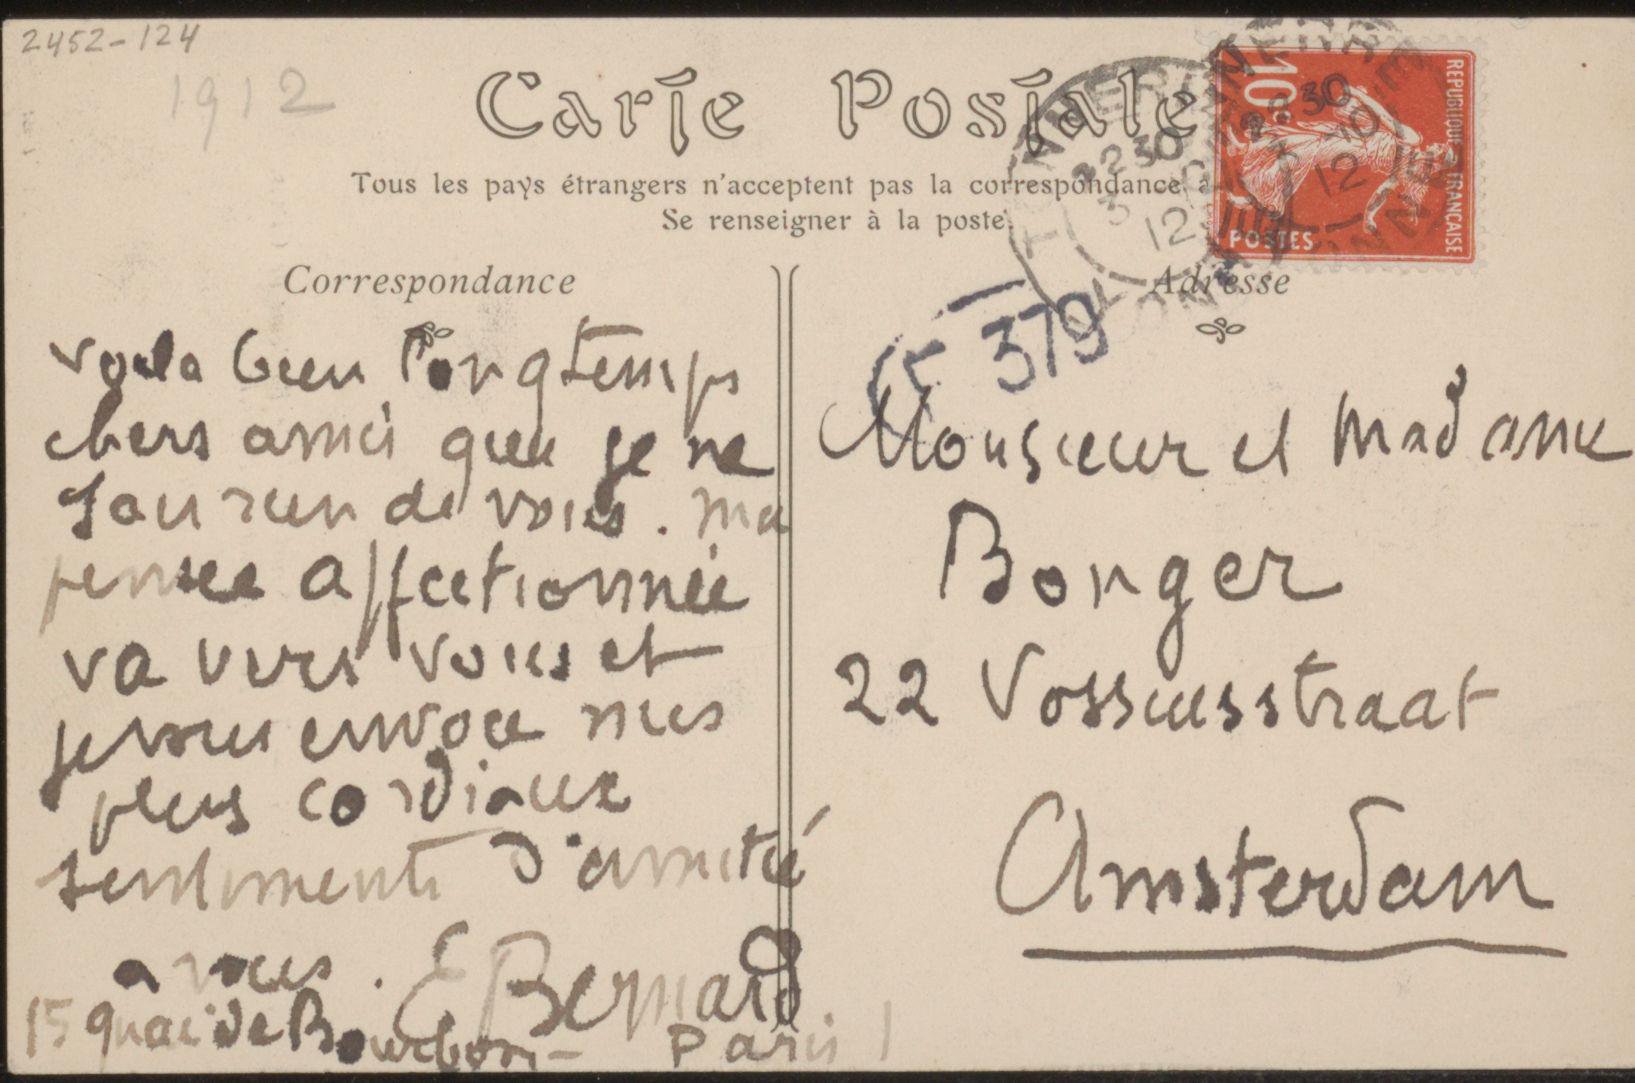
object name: ansichtkaart, prentbriefkaart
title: Prentbriefkaart aan Andries Bonger en Anne Marie Louise van der Linden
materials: cardboard, ink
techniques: photograph, pen, writing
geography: tonnerre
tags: andries bonger